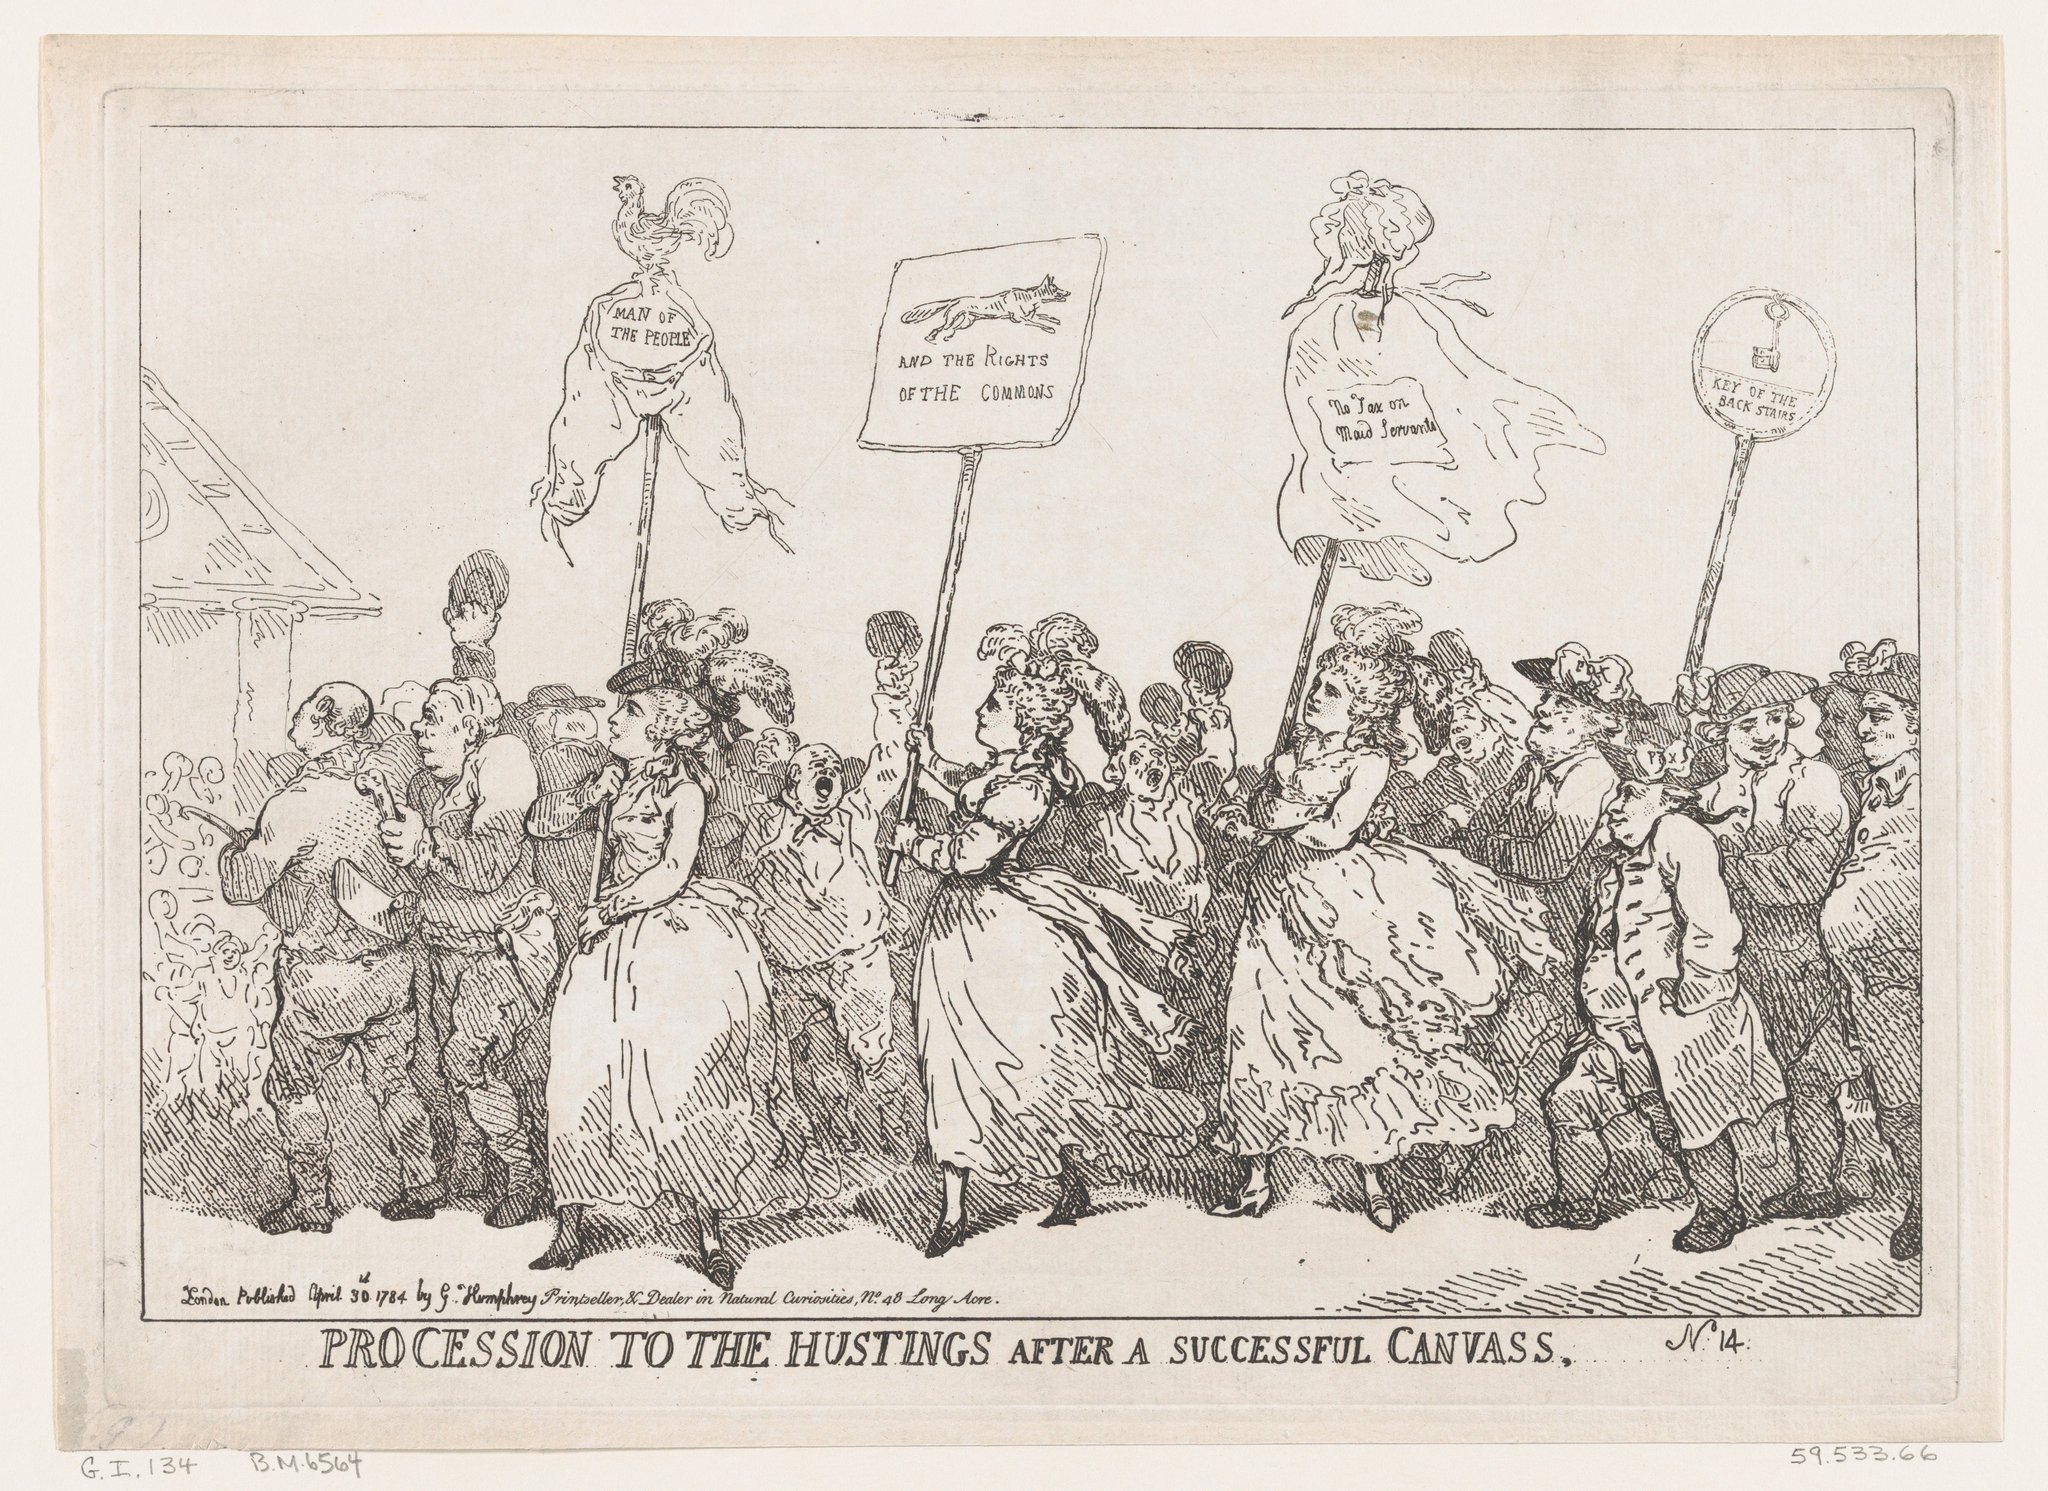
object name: print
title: Procession to The Hustings After A Successful Canvass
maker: thomas rowlandson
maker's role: artist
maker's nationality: british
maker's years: 1757-1827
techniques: etching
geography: london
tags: satire,elections,men,women,politics